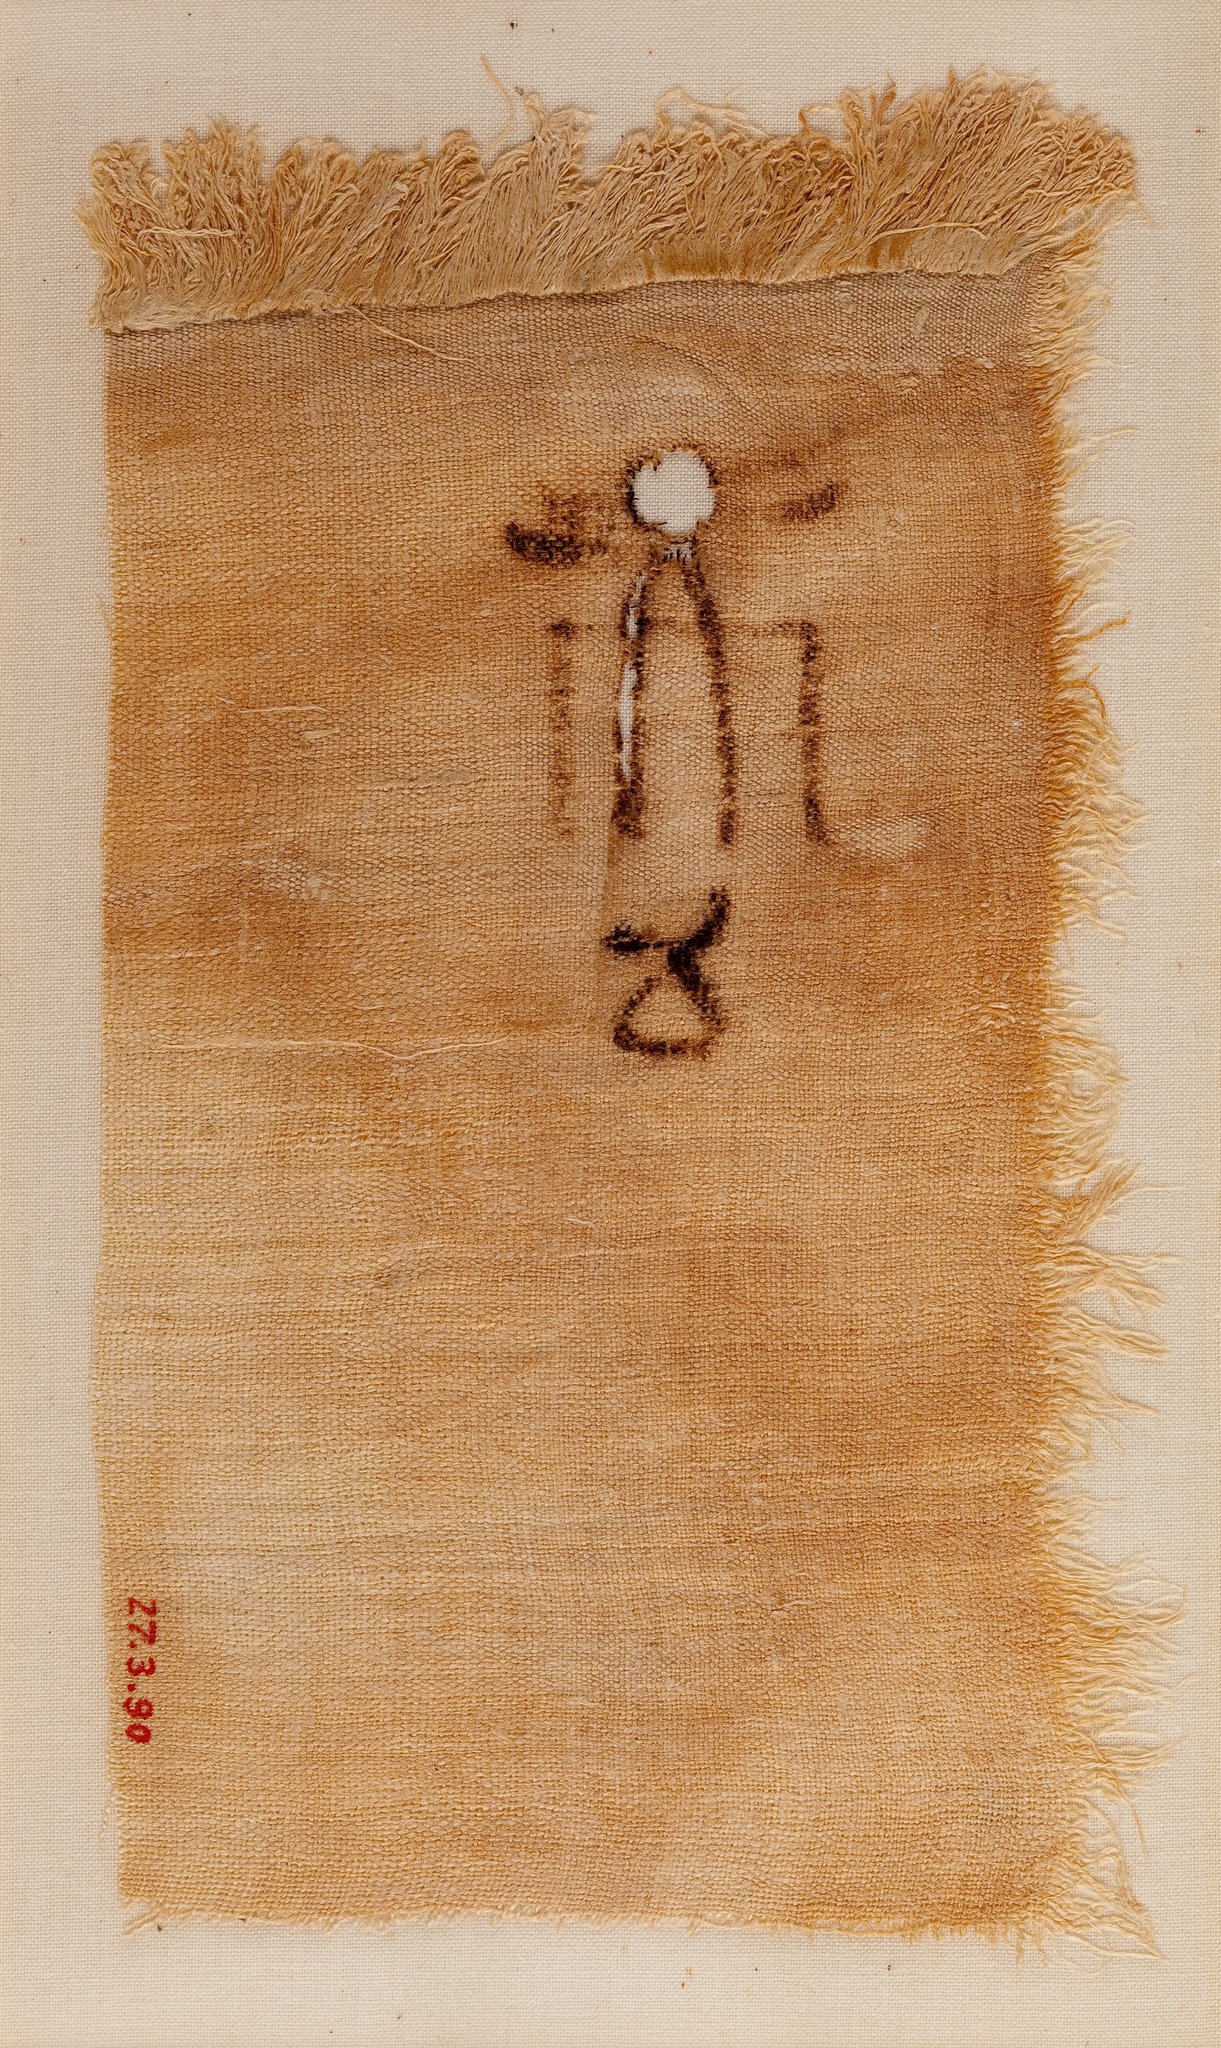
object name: linen mark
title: Linen mark (Type II)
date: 1961-1917 BCE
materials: linen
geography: egypt